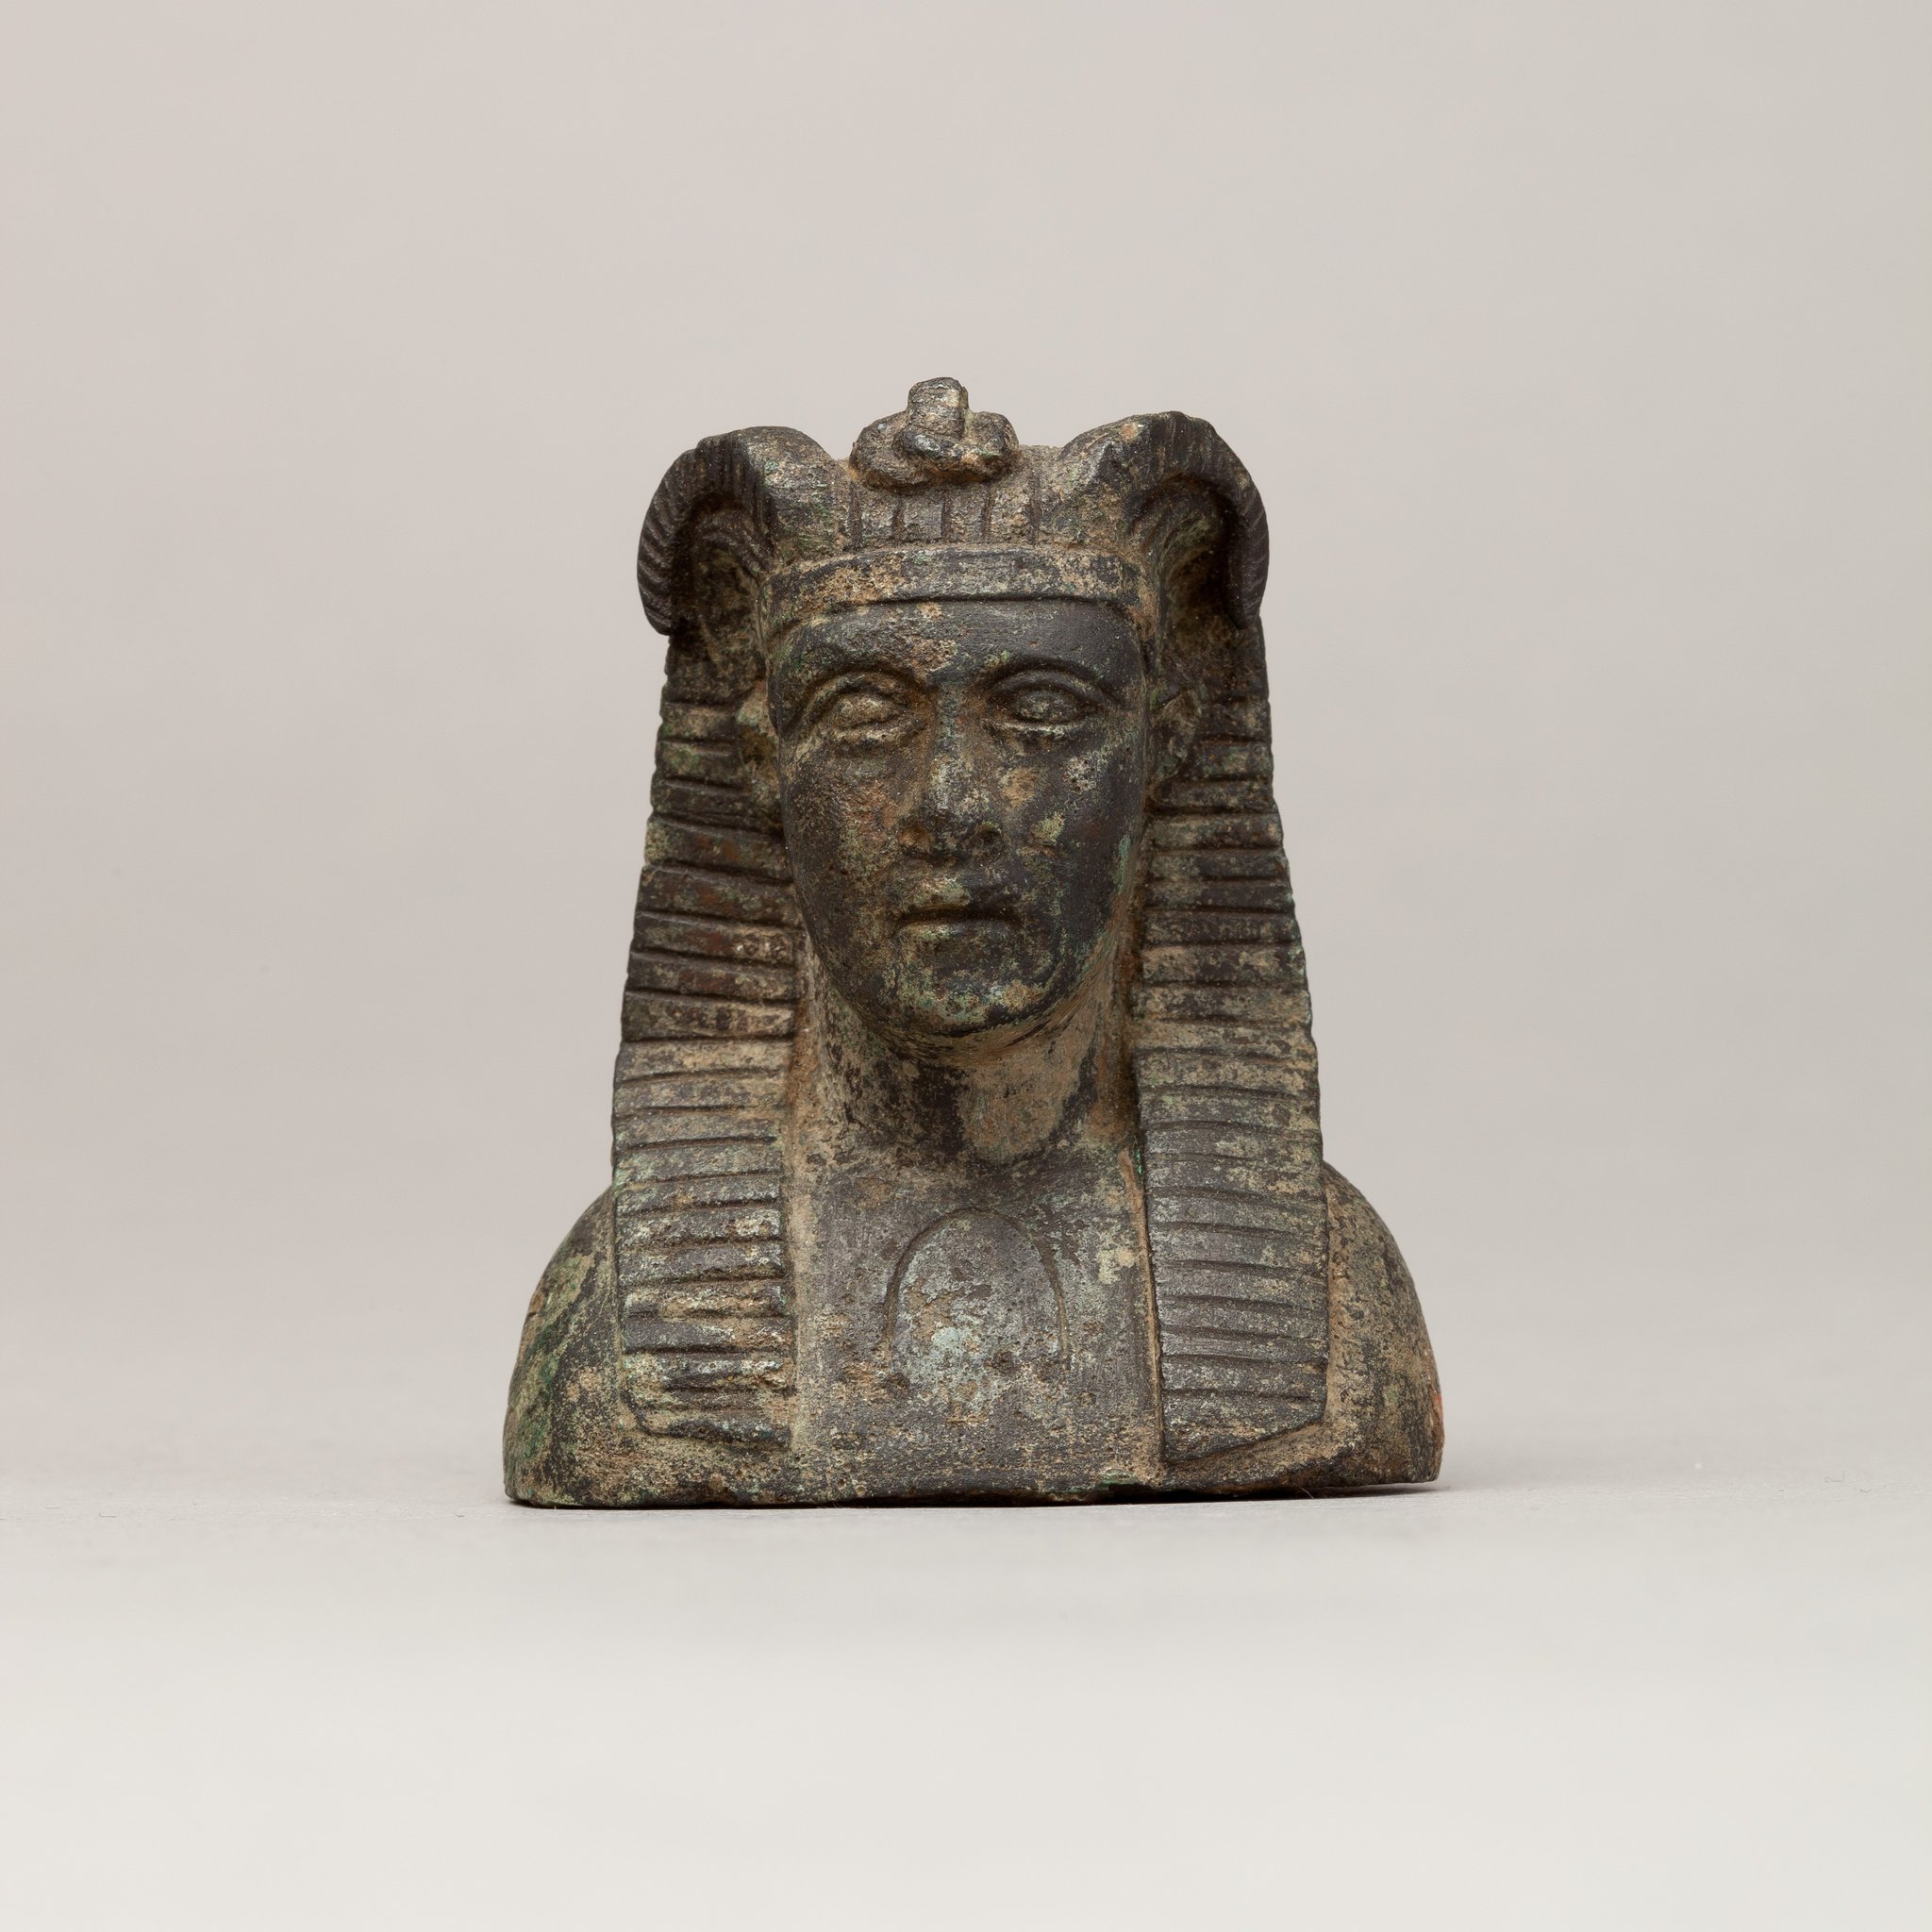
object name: bust, alexander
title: Bust of Alexander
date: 150 BCE-200 CE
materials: copper alloy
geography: egypt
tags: alexander the great